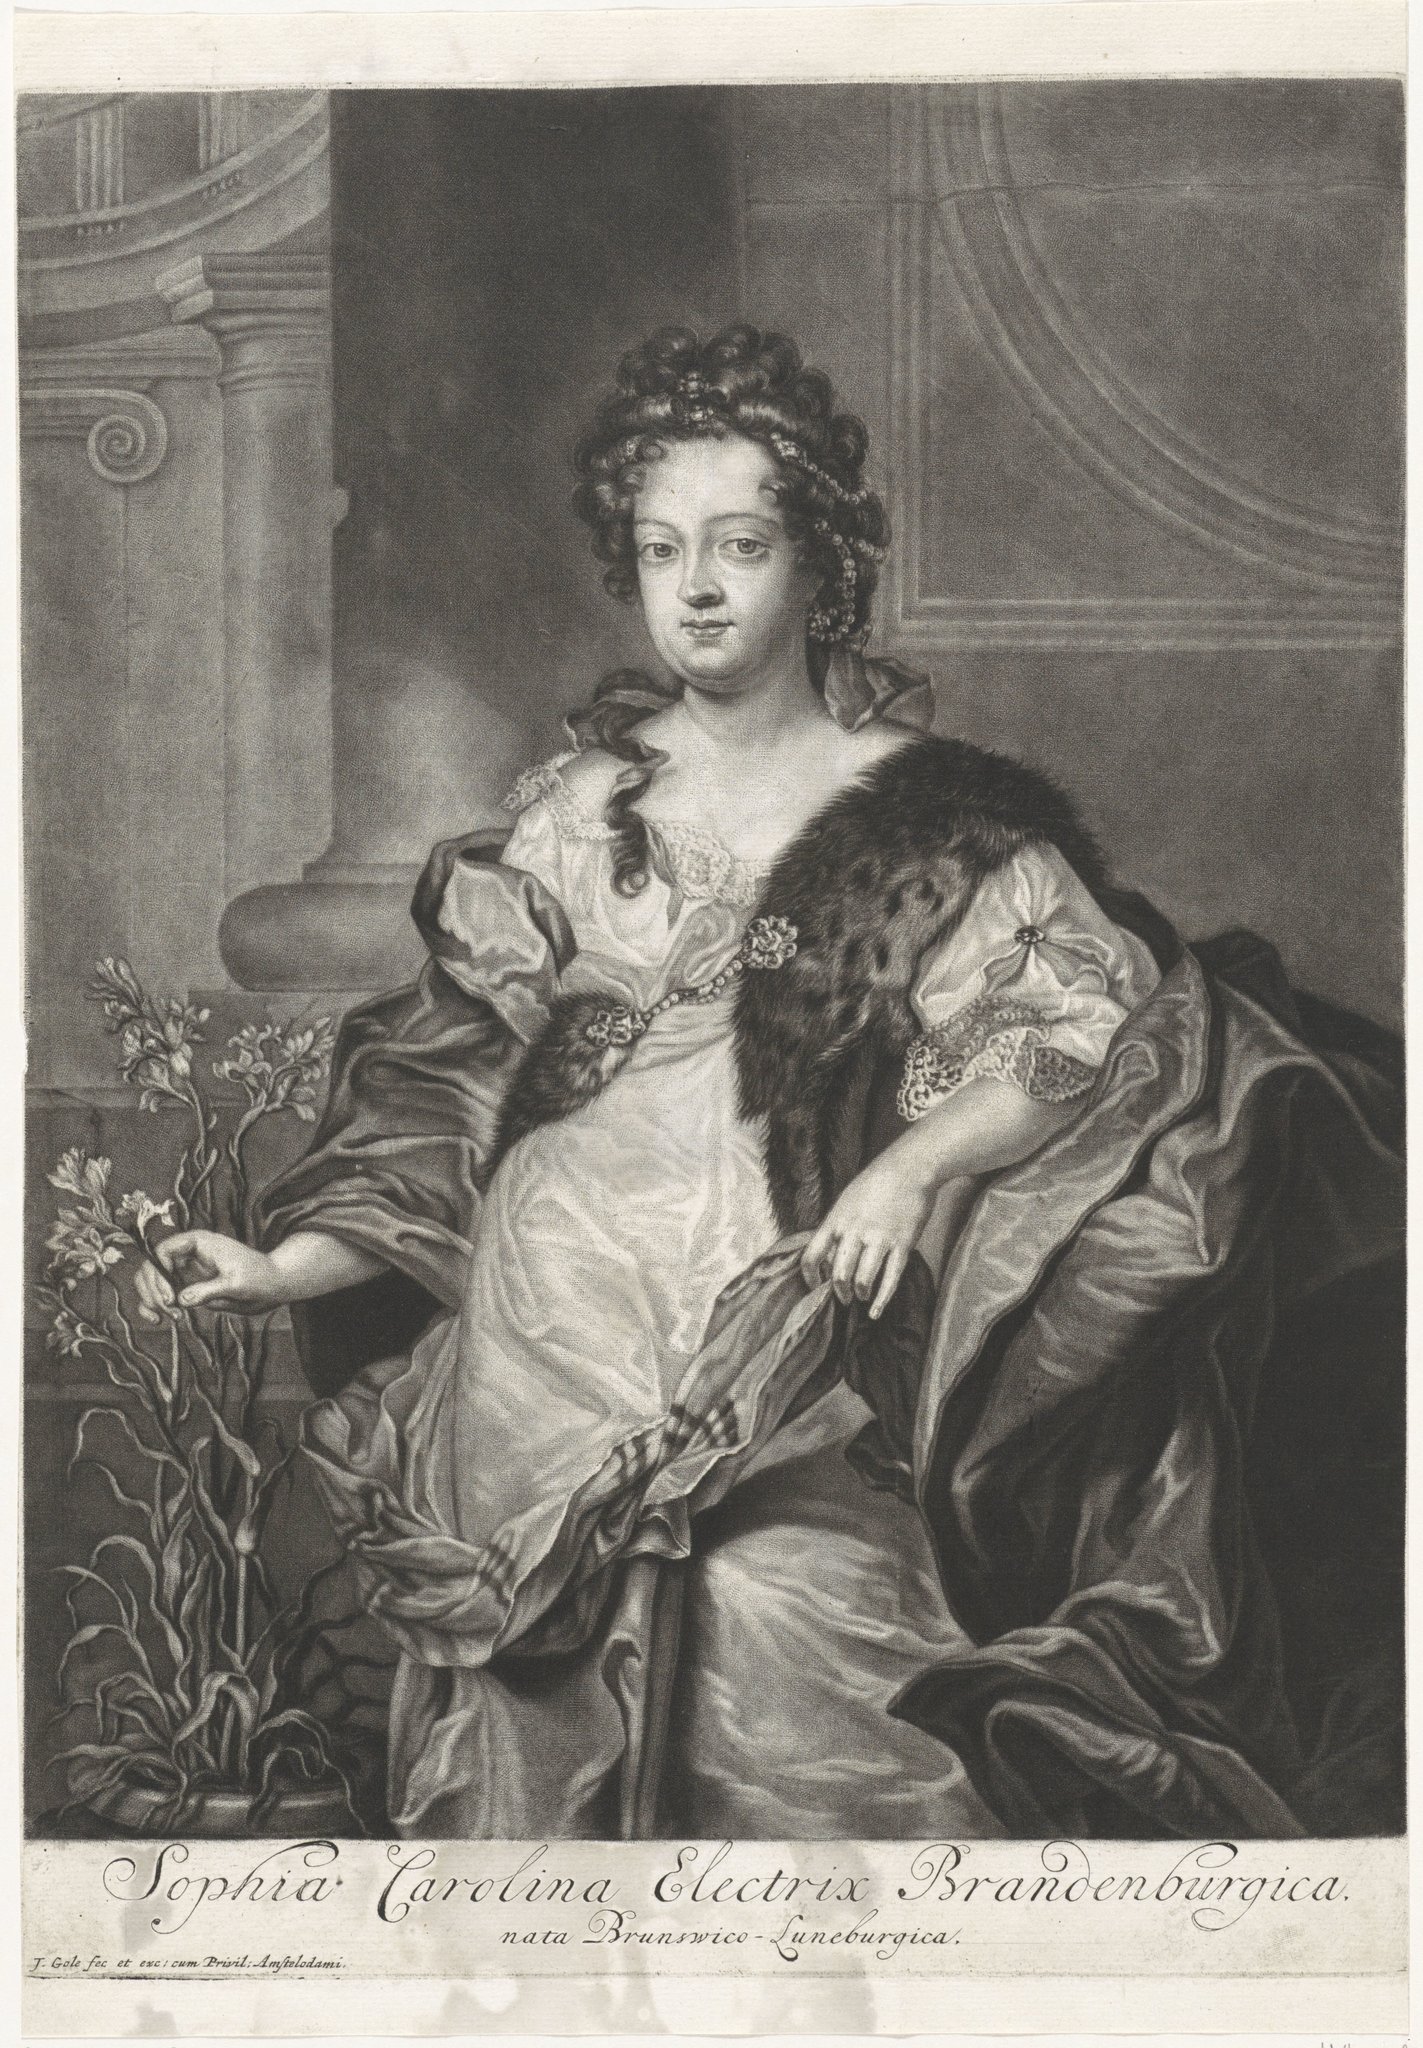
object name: print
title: Sophia Carolina Electrix Brandenburgica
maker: jacob gole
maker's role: print maker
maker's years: 1660-1724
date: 1684-1724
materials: paper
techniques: engraving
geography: amsterdam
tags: berlin, flowers, pearl; pearl necklace (+ women's clothes)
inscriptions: collector's mark: Lugt 2228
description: Sophia Charlotte van Hannover, koningin van Pruisen met parelsnoeren in haar haren. Ze houdt de stengel van een bloem tussen haar vingers. In de marge haar naam en titels.